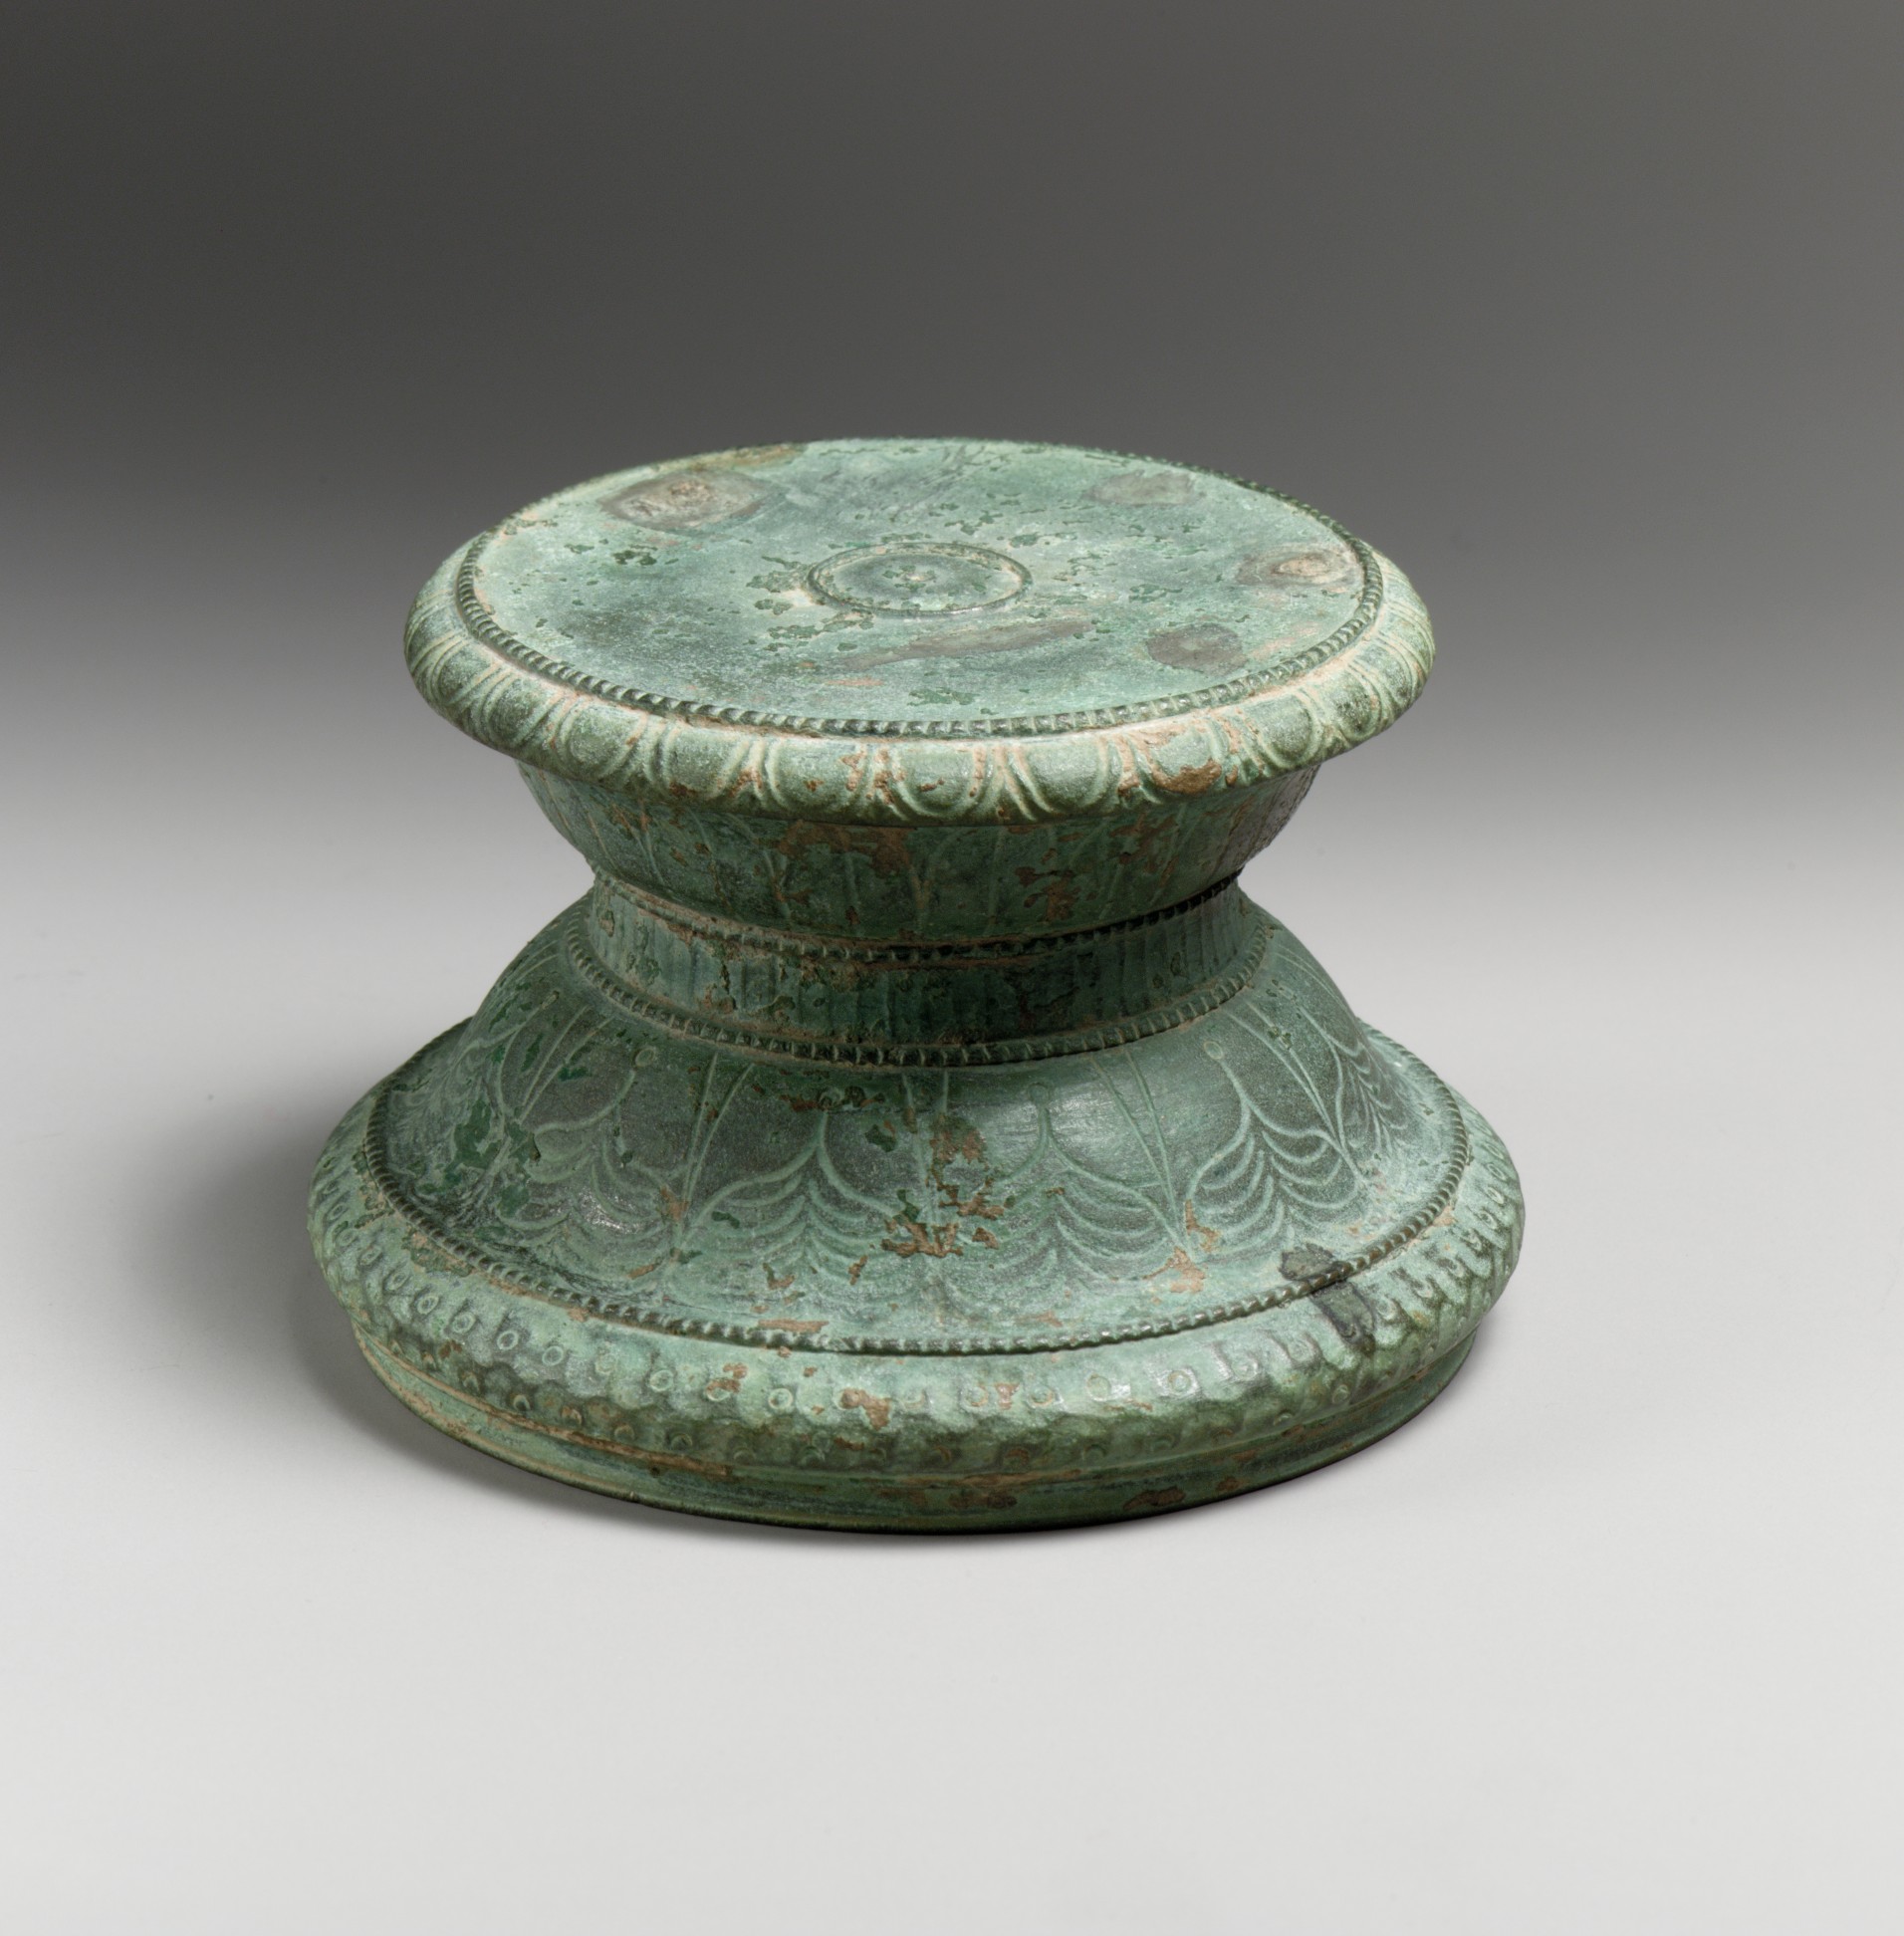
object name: base with floral decoration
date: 7000 BCE-330 CE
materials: bronze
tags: flowers